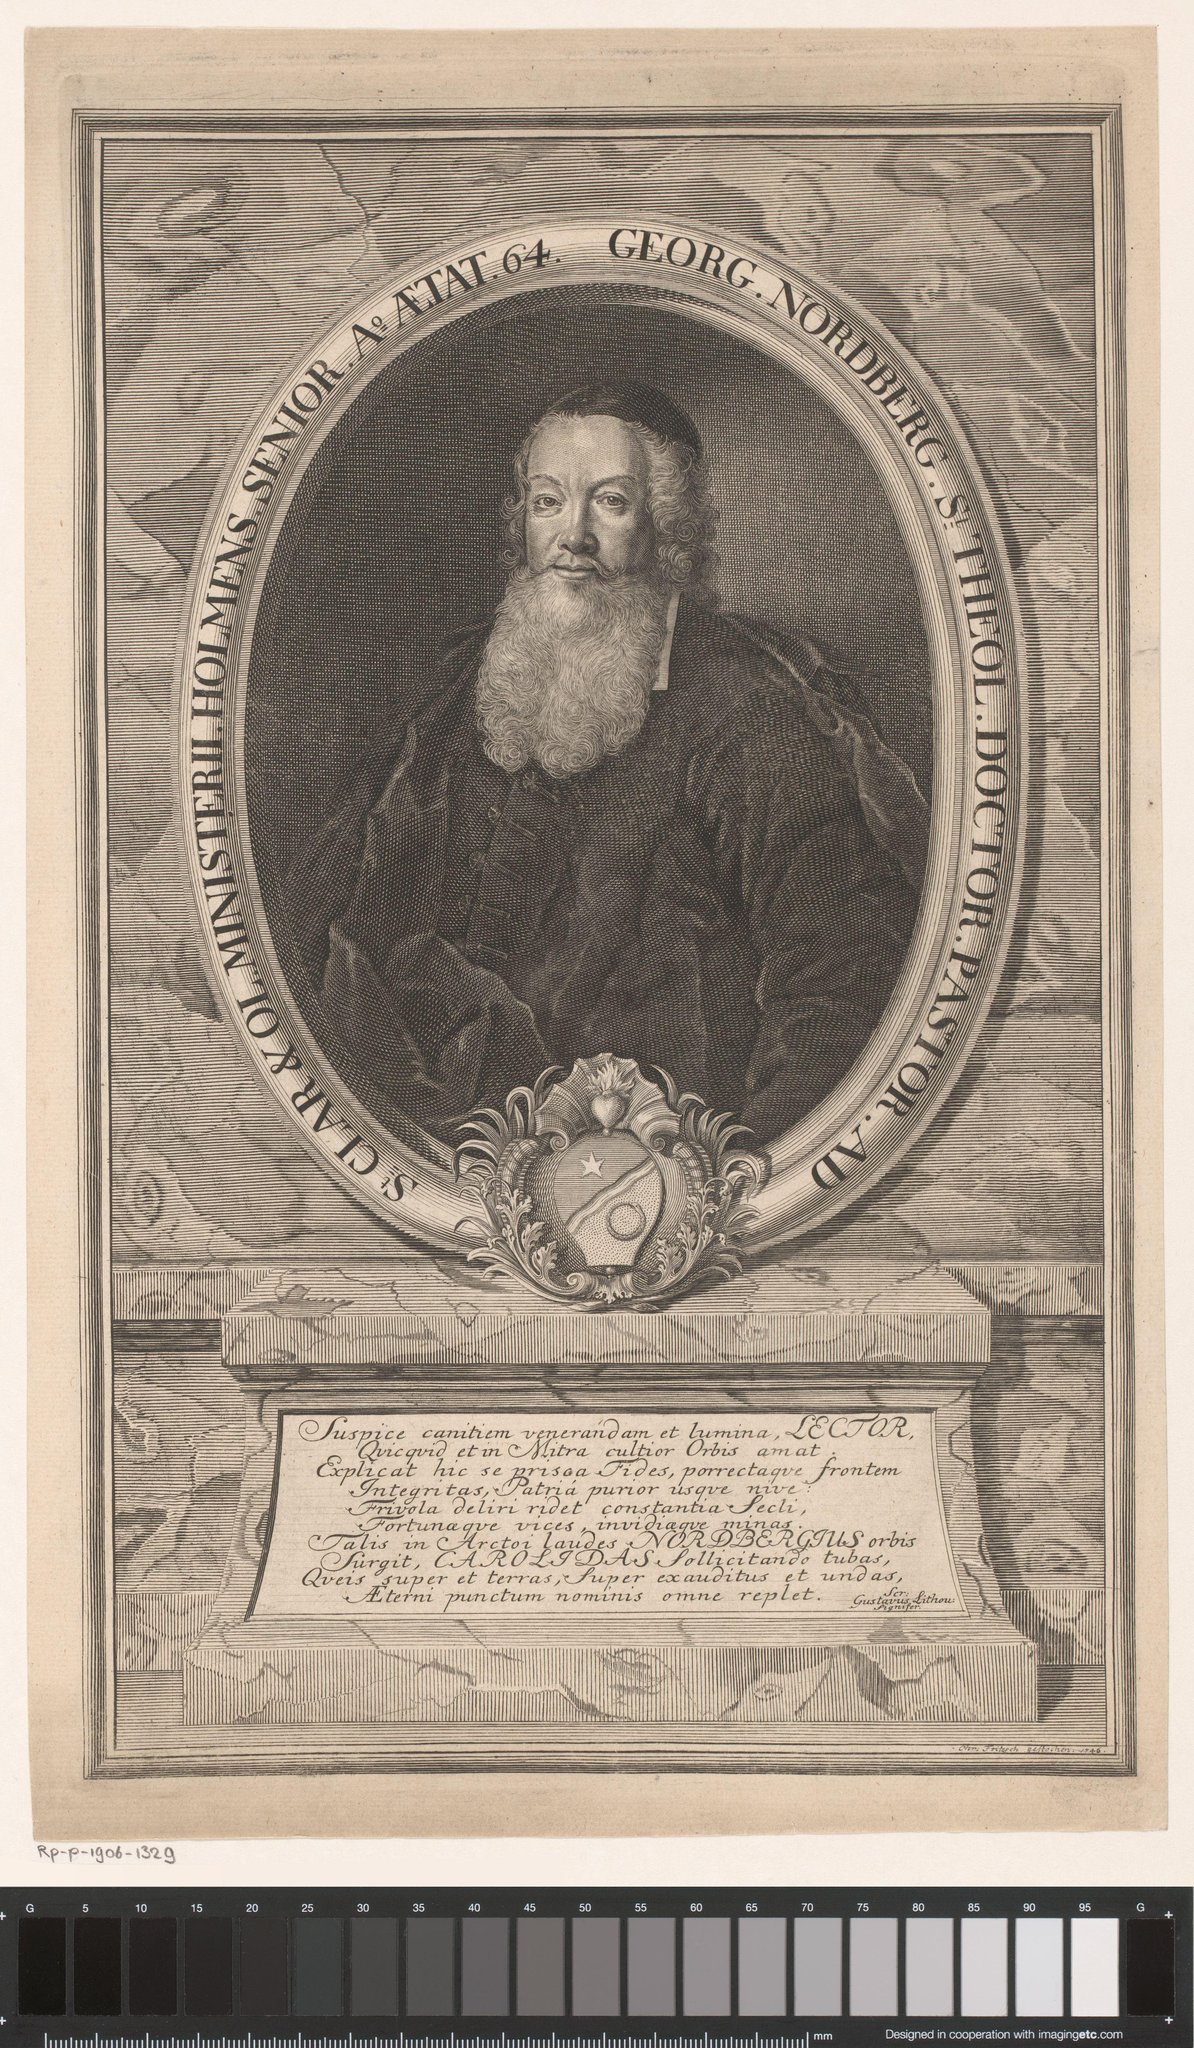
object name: print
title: Portret van Jöran Andersson Nordberg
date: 1746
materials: paper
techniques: engraving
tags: ornament ~ medallion, historical persons, armorial bearing, heraldry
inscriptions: collector's mark: Lugt 2228